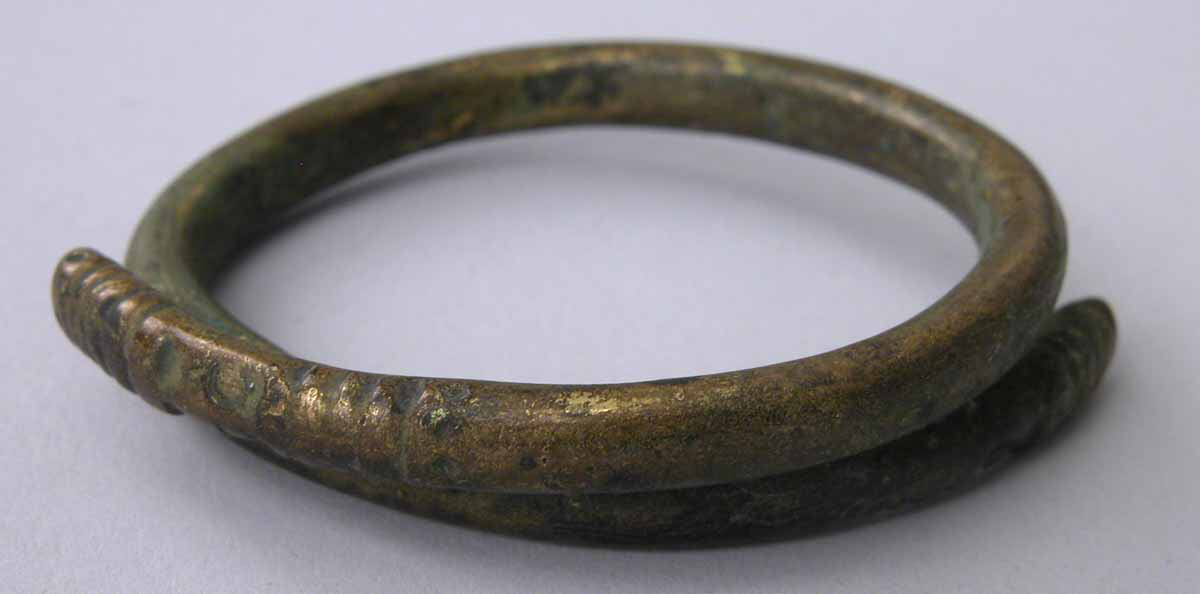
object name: bracelet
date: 501-600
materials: bronze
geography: egypt